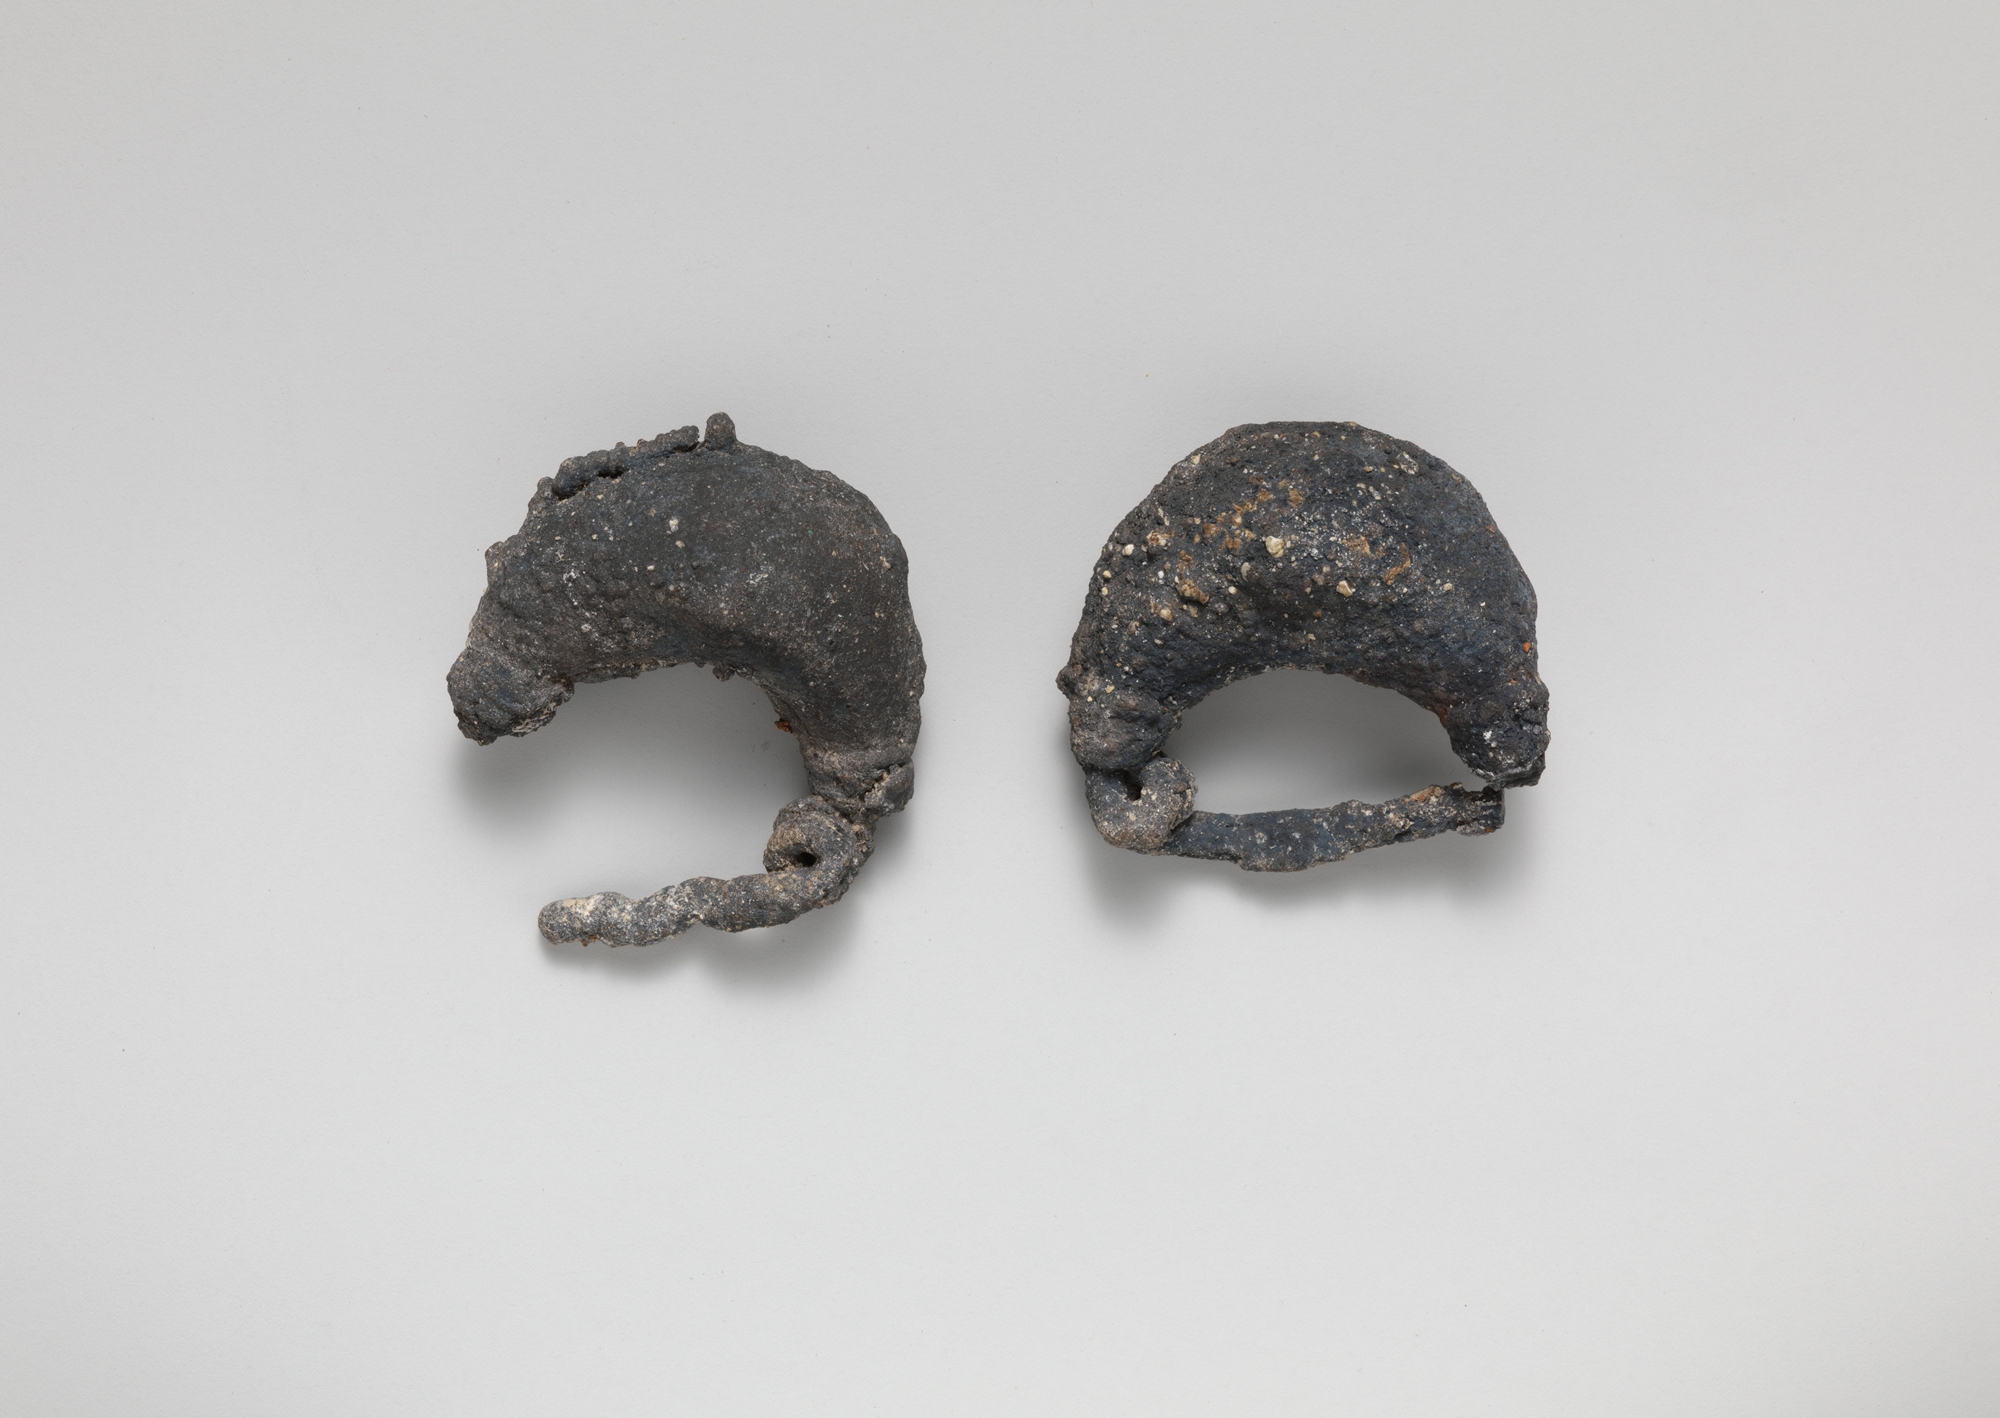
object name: fibula, bow shaped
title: Silver sanguisuga-type fibula (safety pin)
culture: italic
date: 800-601 BCE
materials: silver